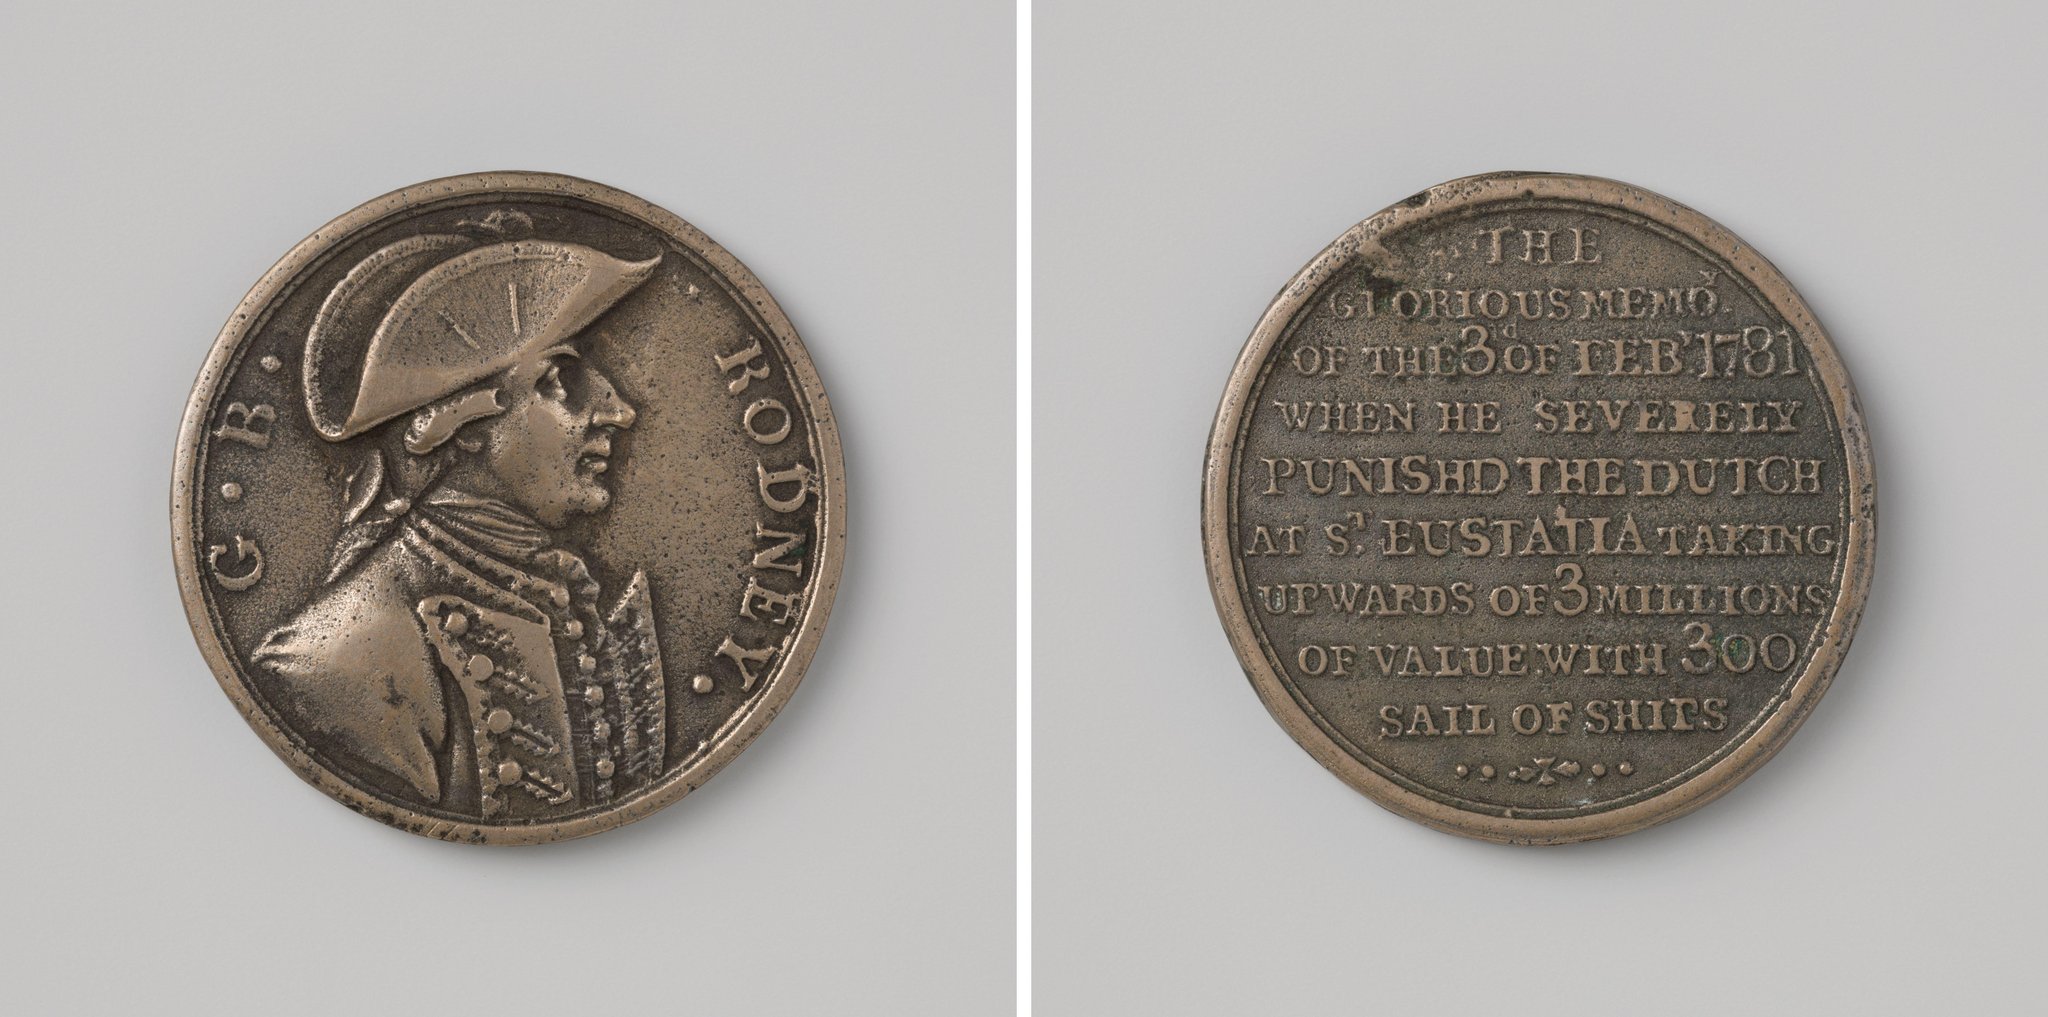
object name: history medal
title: Verovering van Sint Eustatius en verslaan van de Nederlandse vloot door de Engelsen, ter ere van admiraal George Brydges Rodney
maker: Anonymous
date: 1781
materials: alloy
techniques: striking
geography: england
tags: haarlem, fourth anglo-dutch war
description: Penning. Voorzijde: borststuk man met hoed binnen omschrift. Keerzijde: opschrift